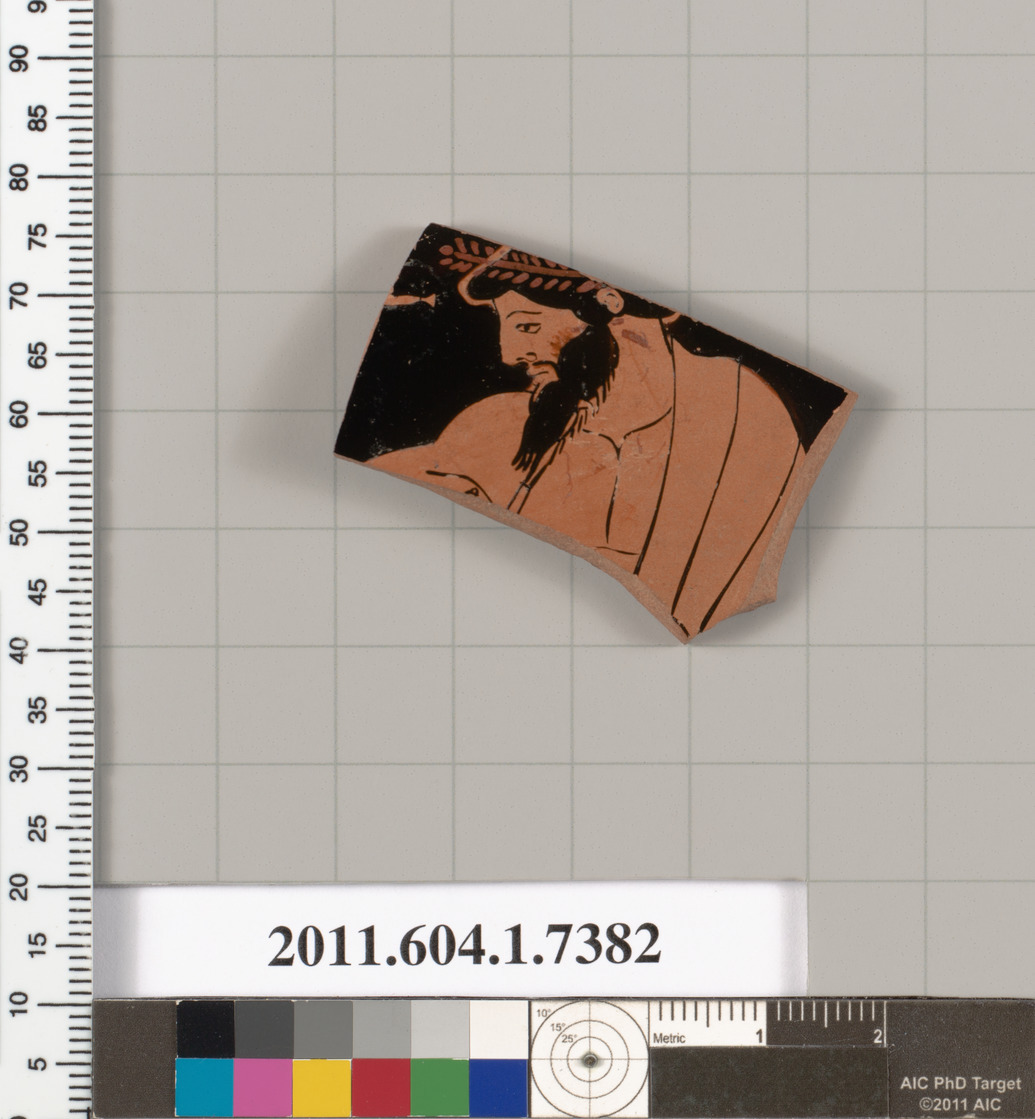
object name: kylix fragment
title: Terracotta fragment of a kylix (drinking cup)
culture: greek, attic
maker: makron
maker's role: artist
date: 500-480 BCE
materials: terracotta